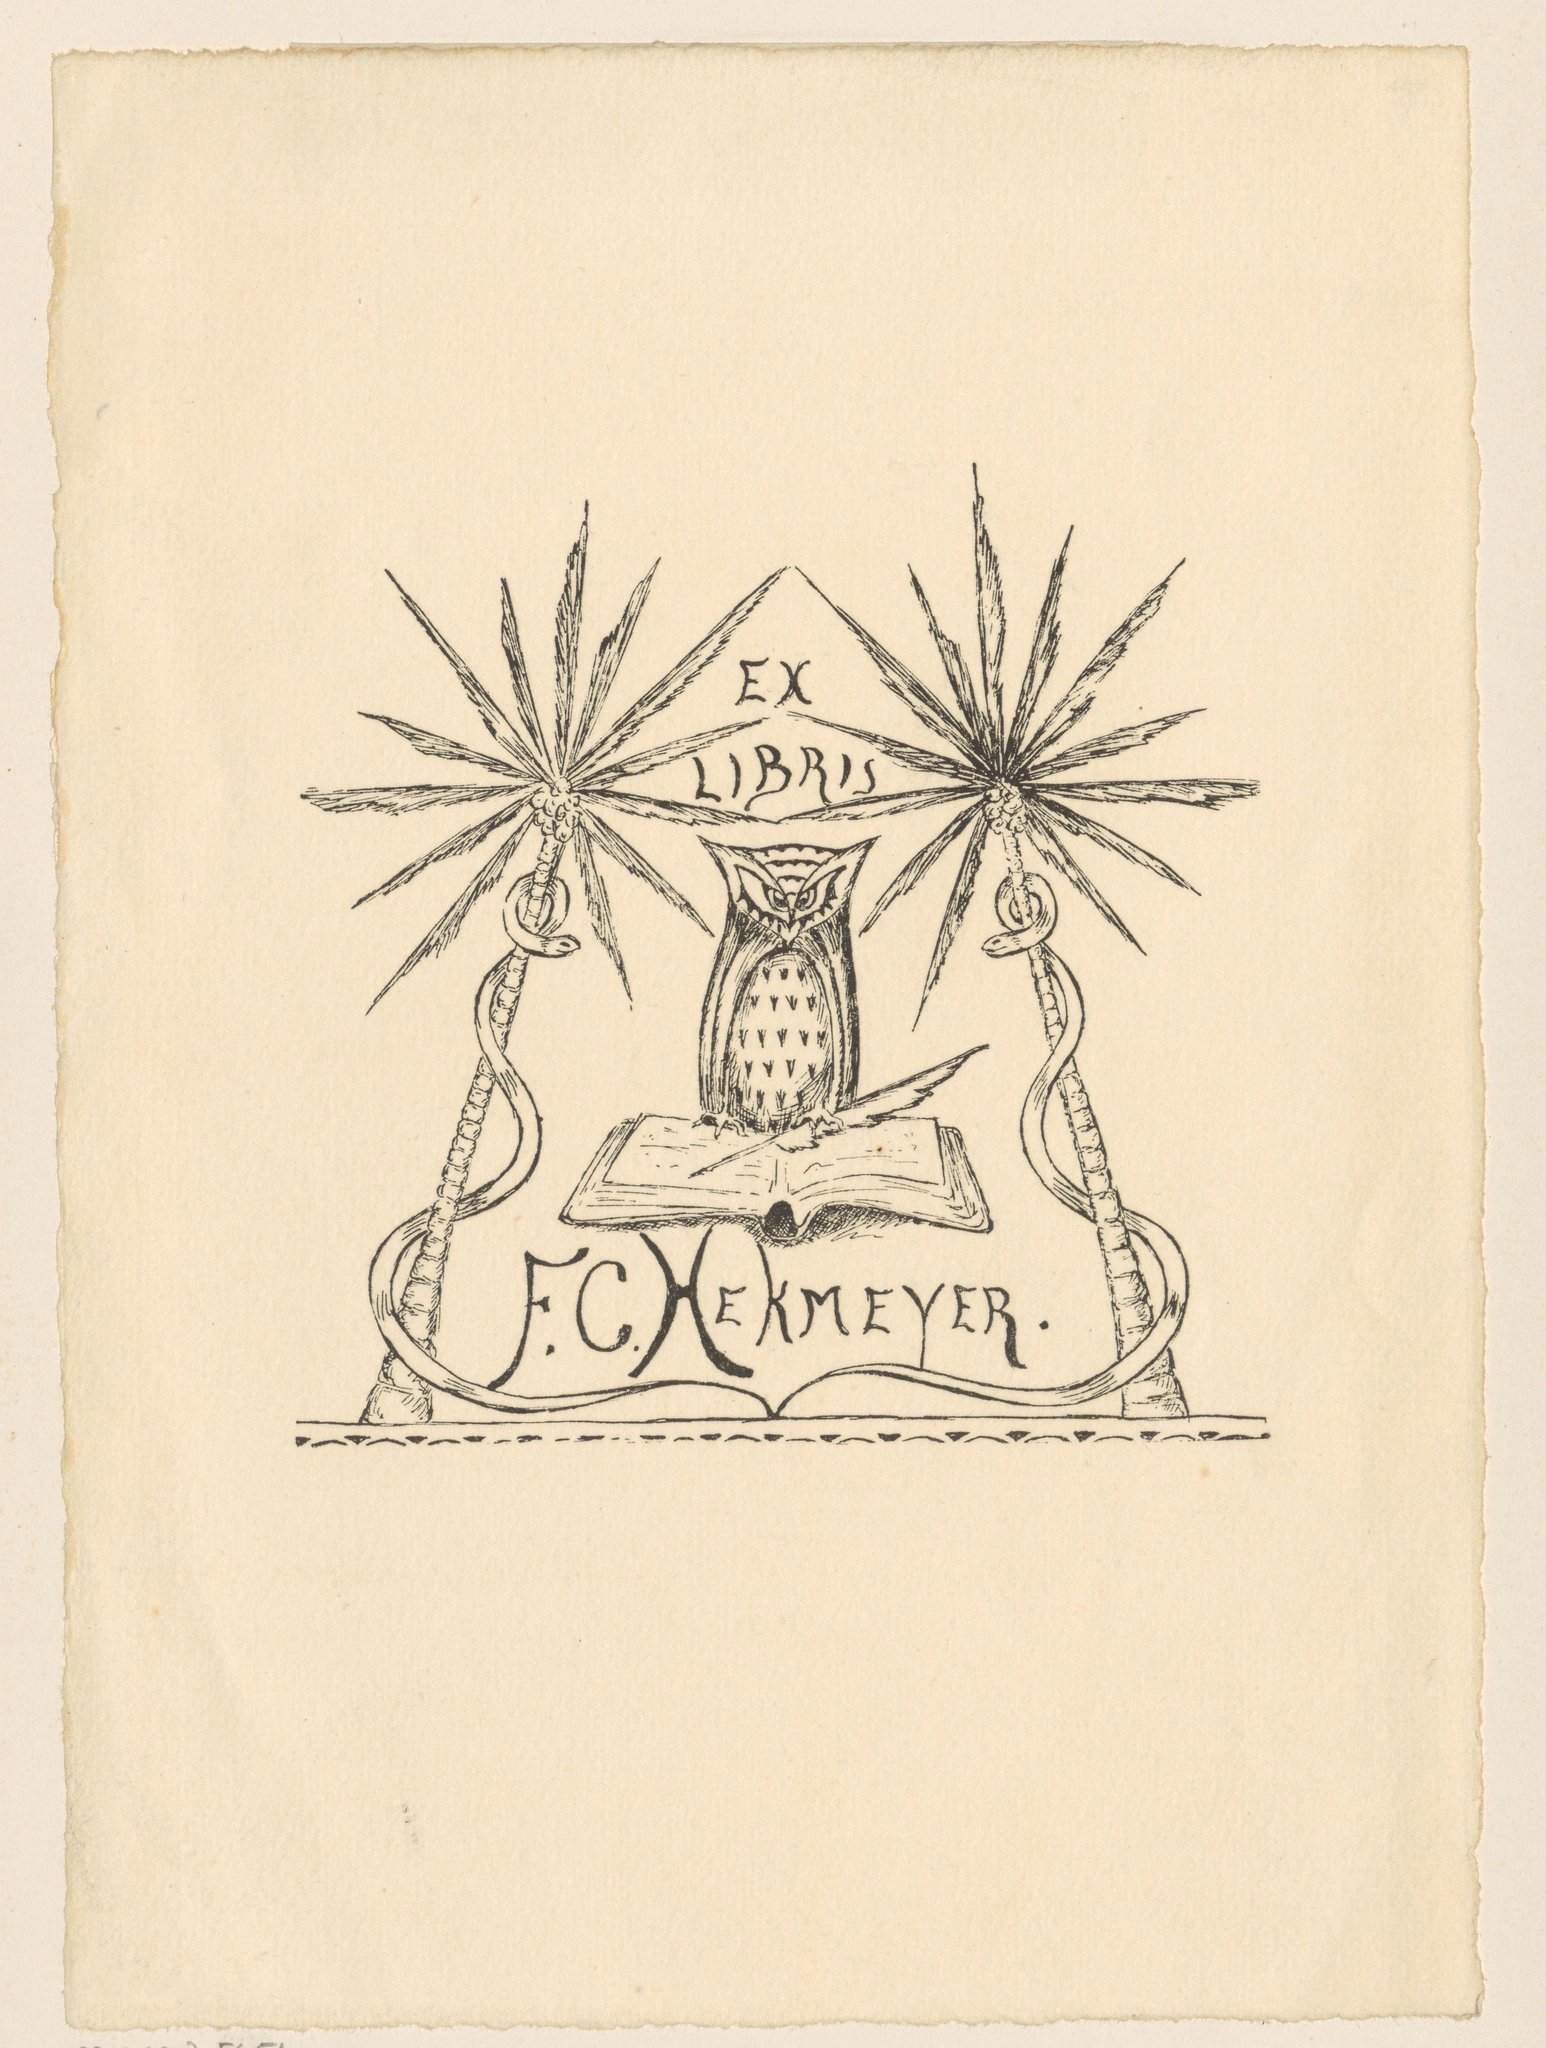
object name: bookplate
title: Ex libris van F.C. Hekmeyer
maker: Anonymous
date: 1890-1923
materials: paper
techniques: lithograph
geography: netherlands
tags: snakes, quill, book, owls, trees: palm-tree